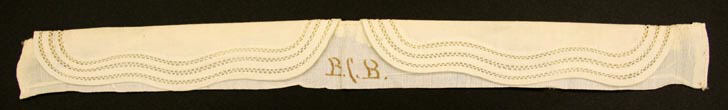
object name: collar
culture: american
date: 1700-1941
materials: cotton